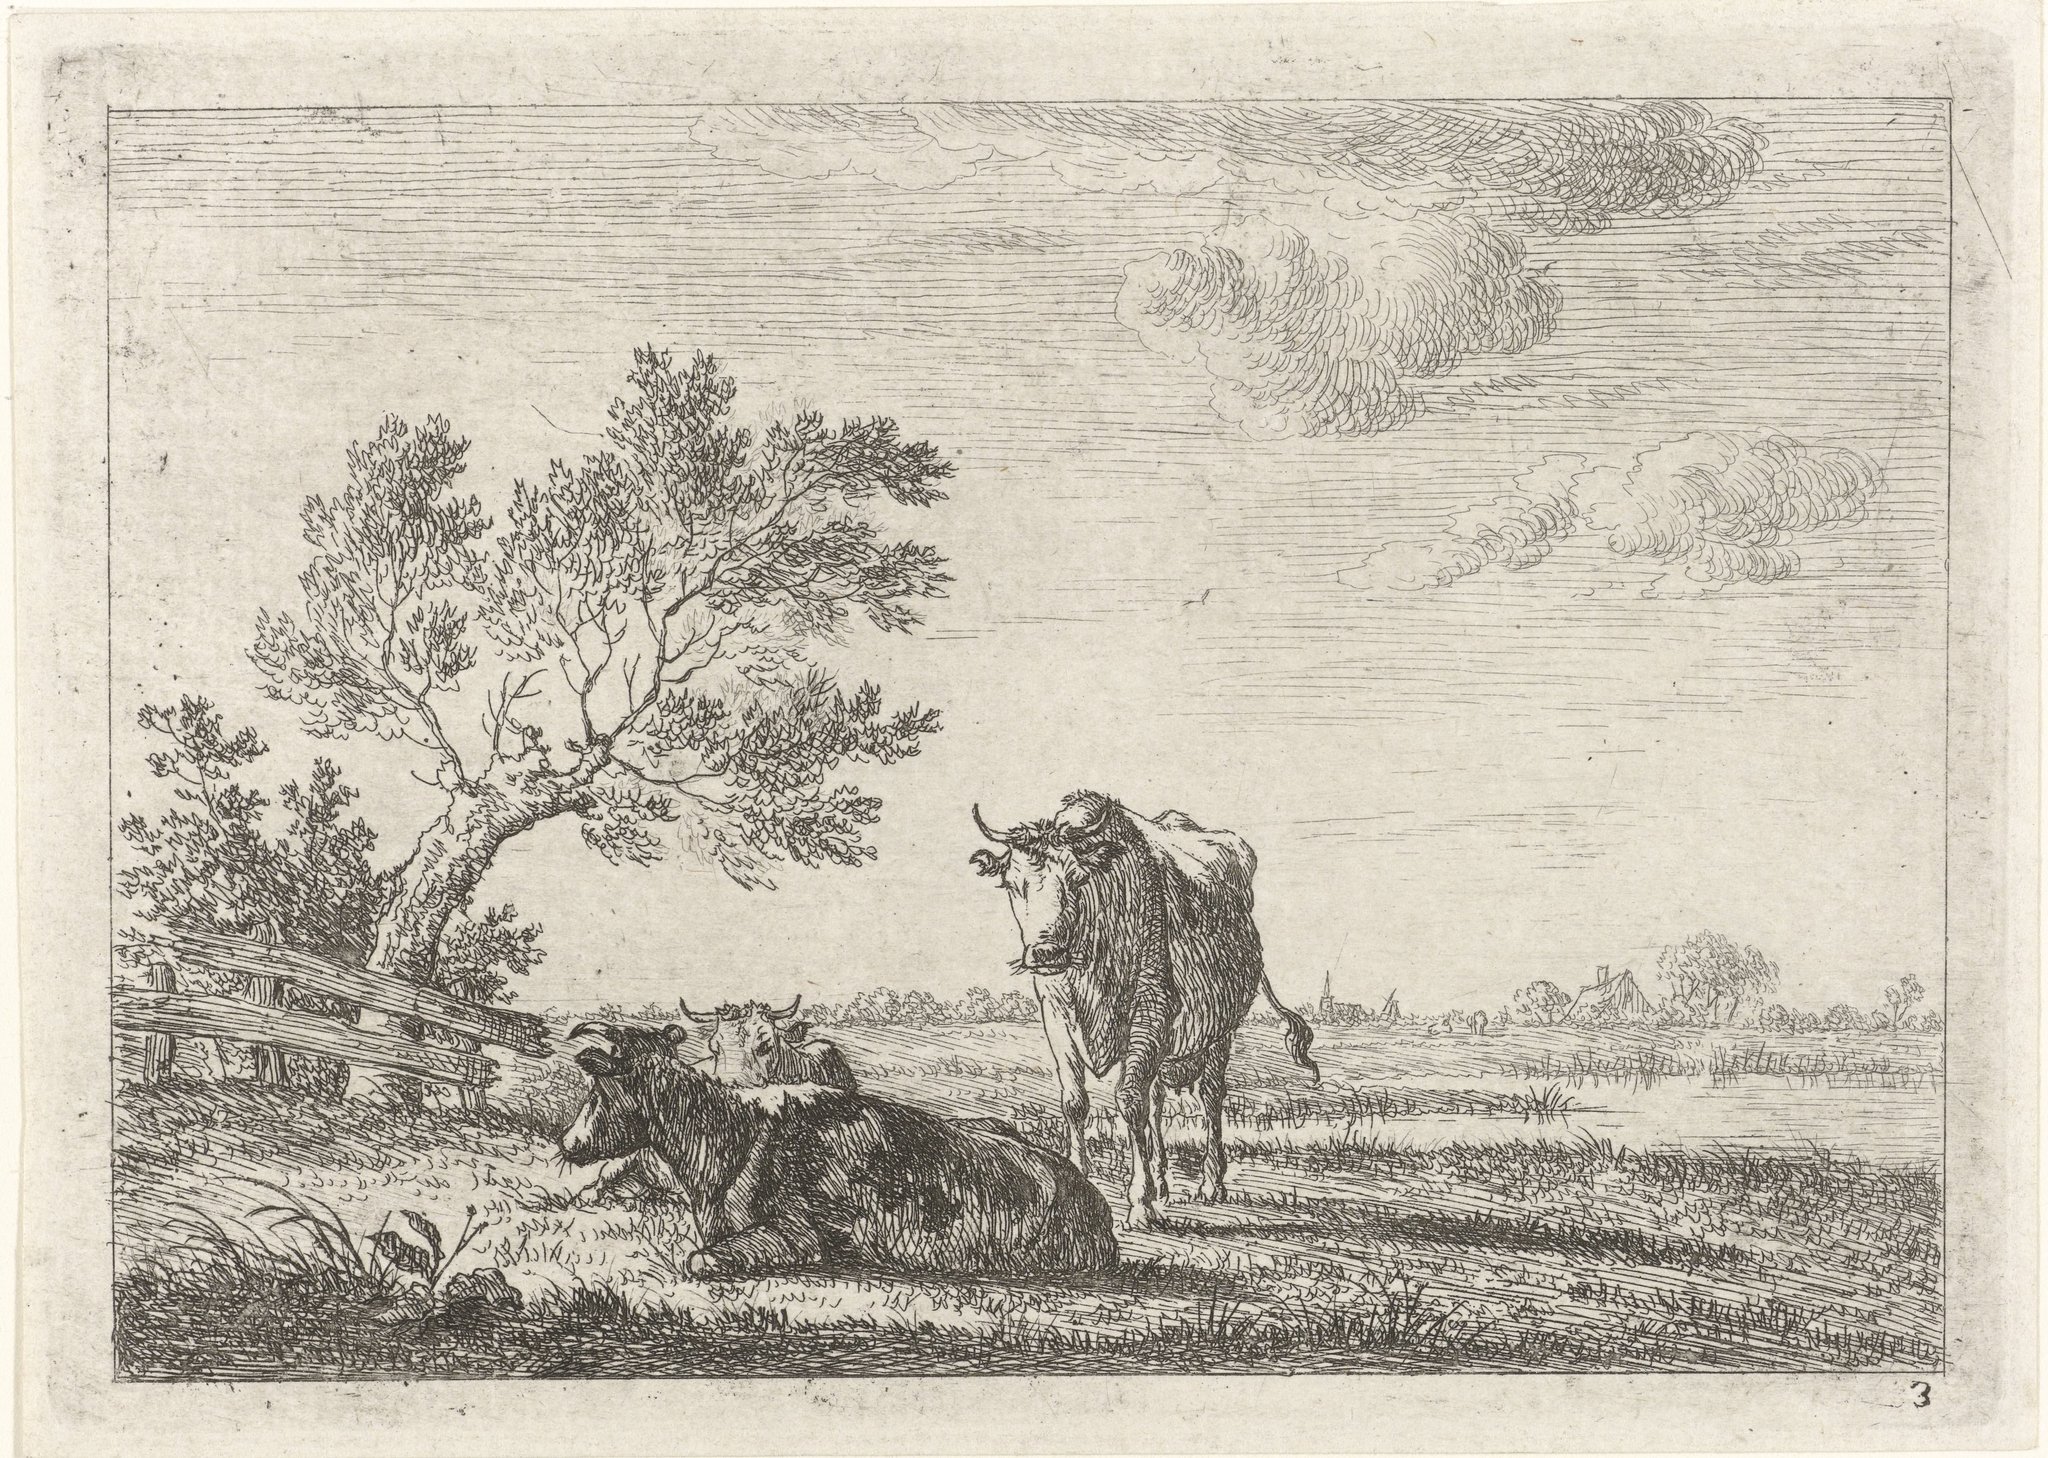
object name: print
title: Landschappen met vee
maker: johannes janson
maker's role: draughtsman, painter, print maker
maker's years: 1729-1784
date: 1761-1784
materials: paper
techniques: etching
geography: leiden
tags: cow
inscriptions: collector's mark: Lugt 2228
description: Drie koeien, twee liggend en één staand, bij meer in weiland. Derde prent uit een serie van acht met landschappen met vee.